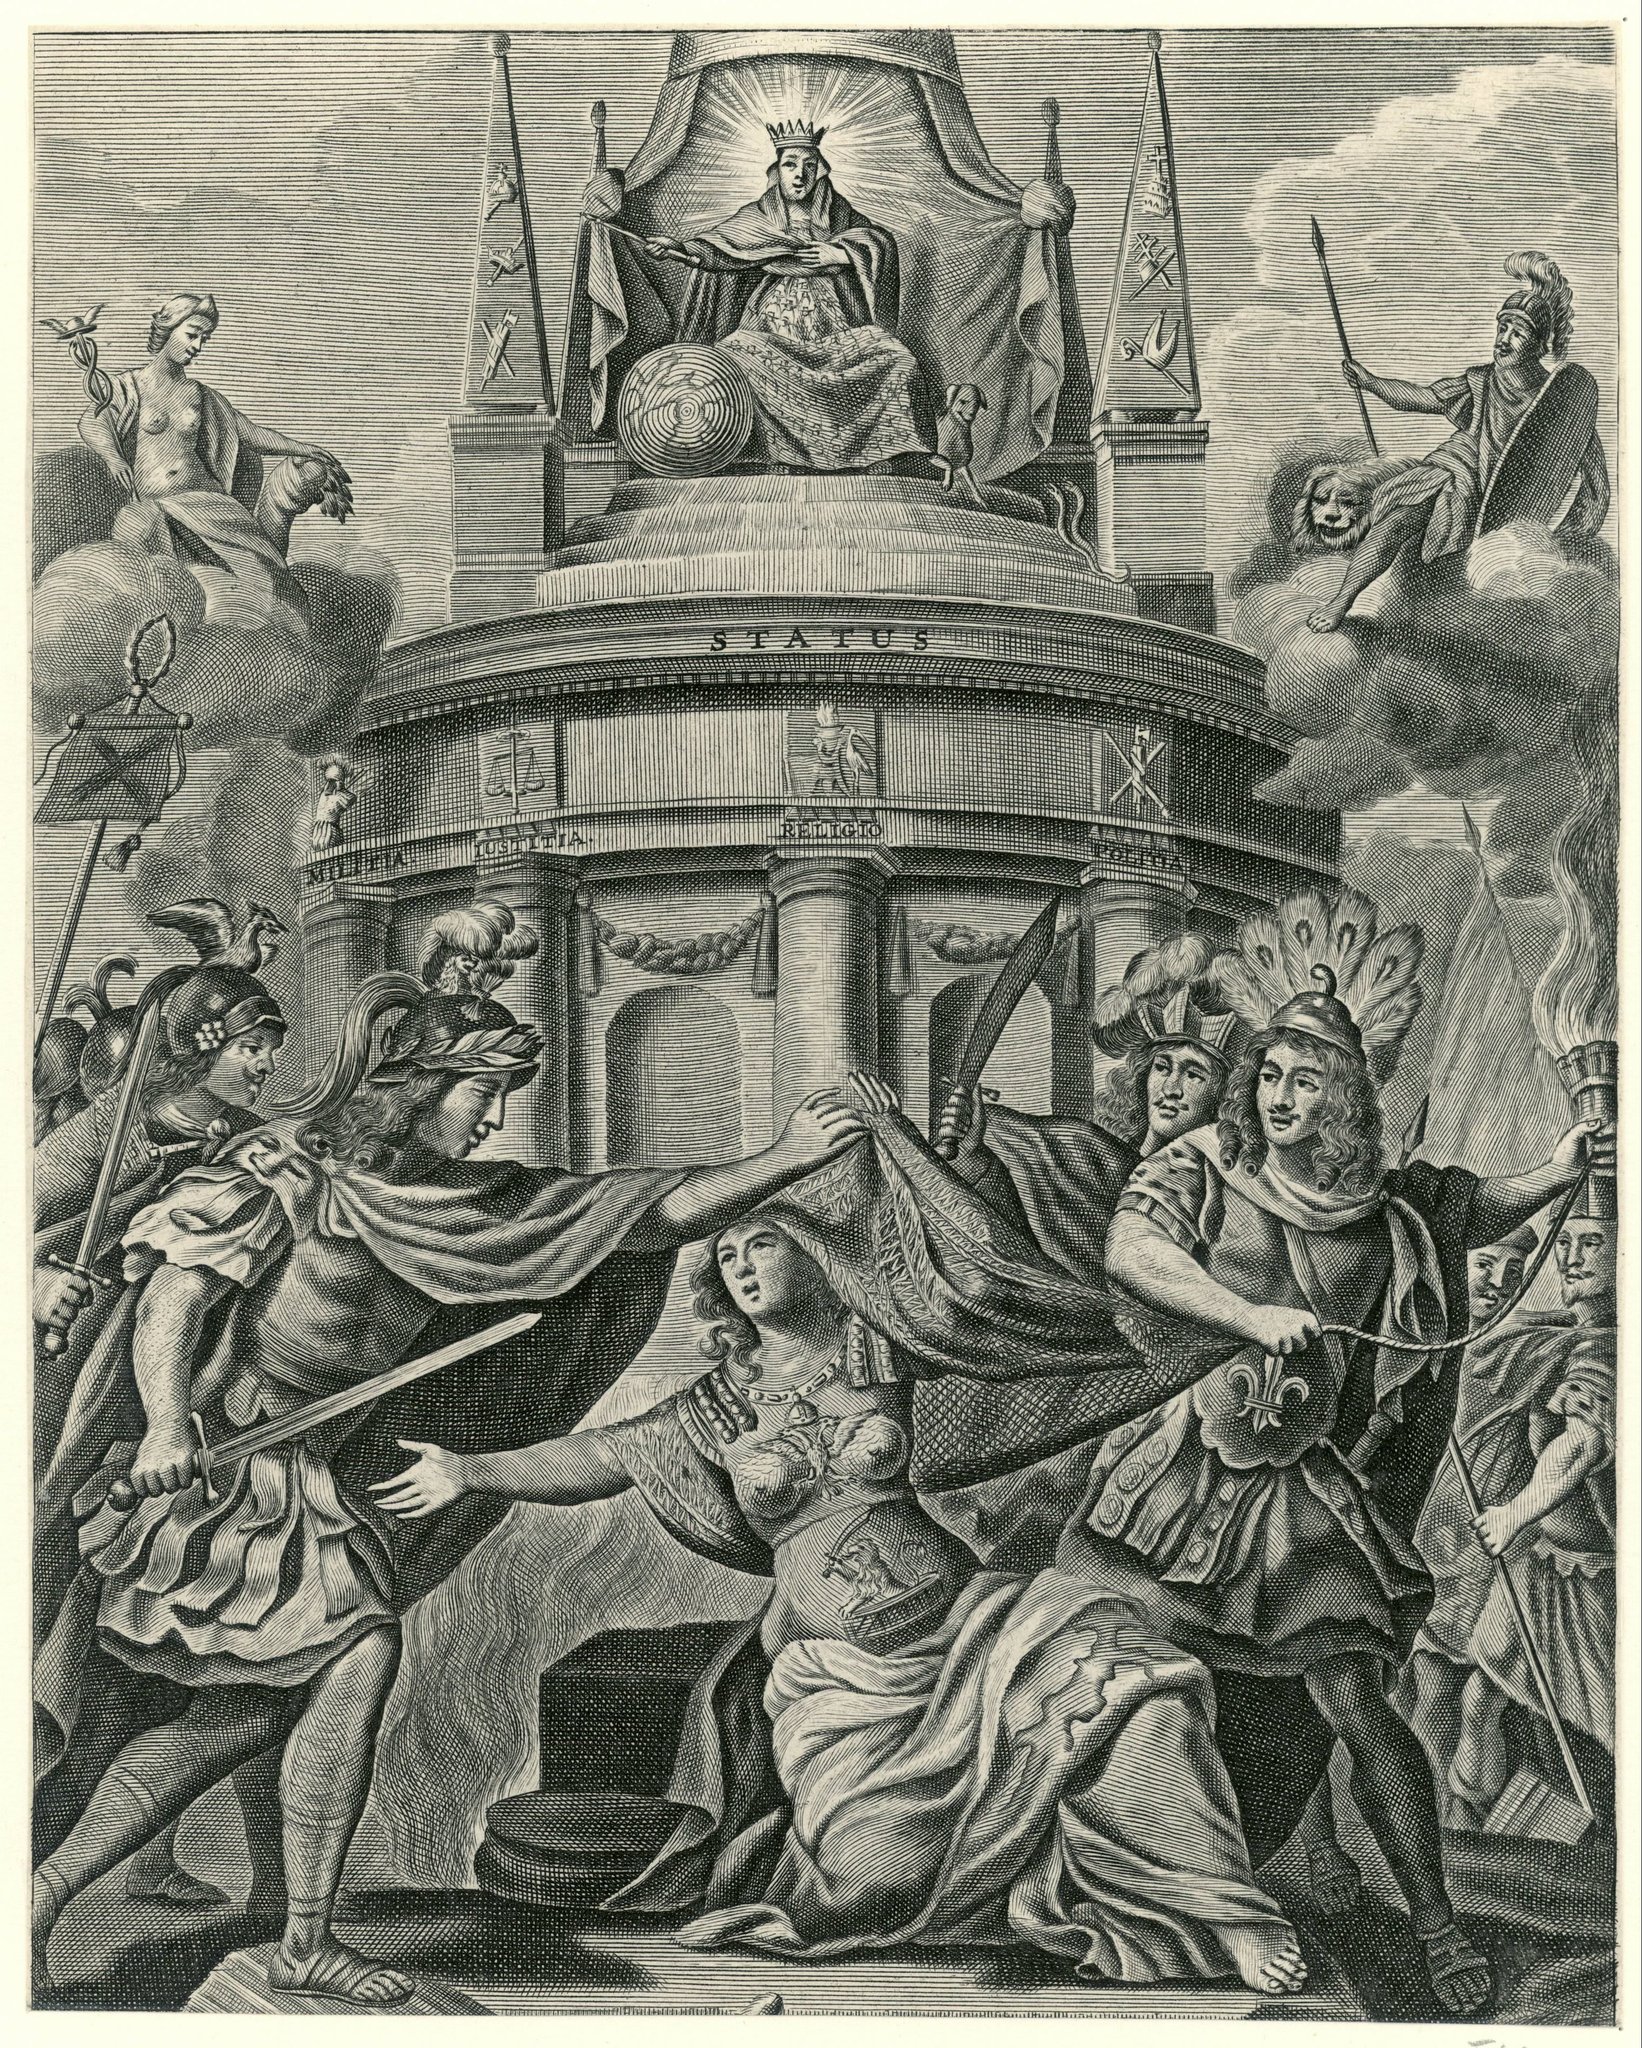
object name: print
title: Willem III komt Nederland te hulp, 1672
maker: Anonymous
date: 1672-1683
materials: paper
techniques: engraving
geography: northern netherlands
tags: the hague, william iii (prince of orange and king of england, scotland, and ireland), lodewijk xiv (koning van frankrijk), personifications of countries, nations, states, districts, etc., netherlands, rampjaar (disaster year)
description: Willem III redt de Nederlandse Maagd uit de handen van Frankrijk en Engeland die een net over haar trachten te gooien, 1672. Op de achtergrond een tempel aangeduid als Status met symbolen van Militia, Justitia, Religio en Politia.